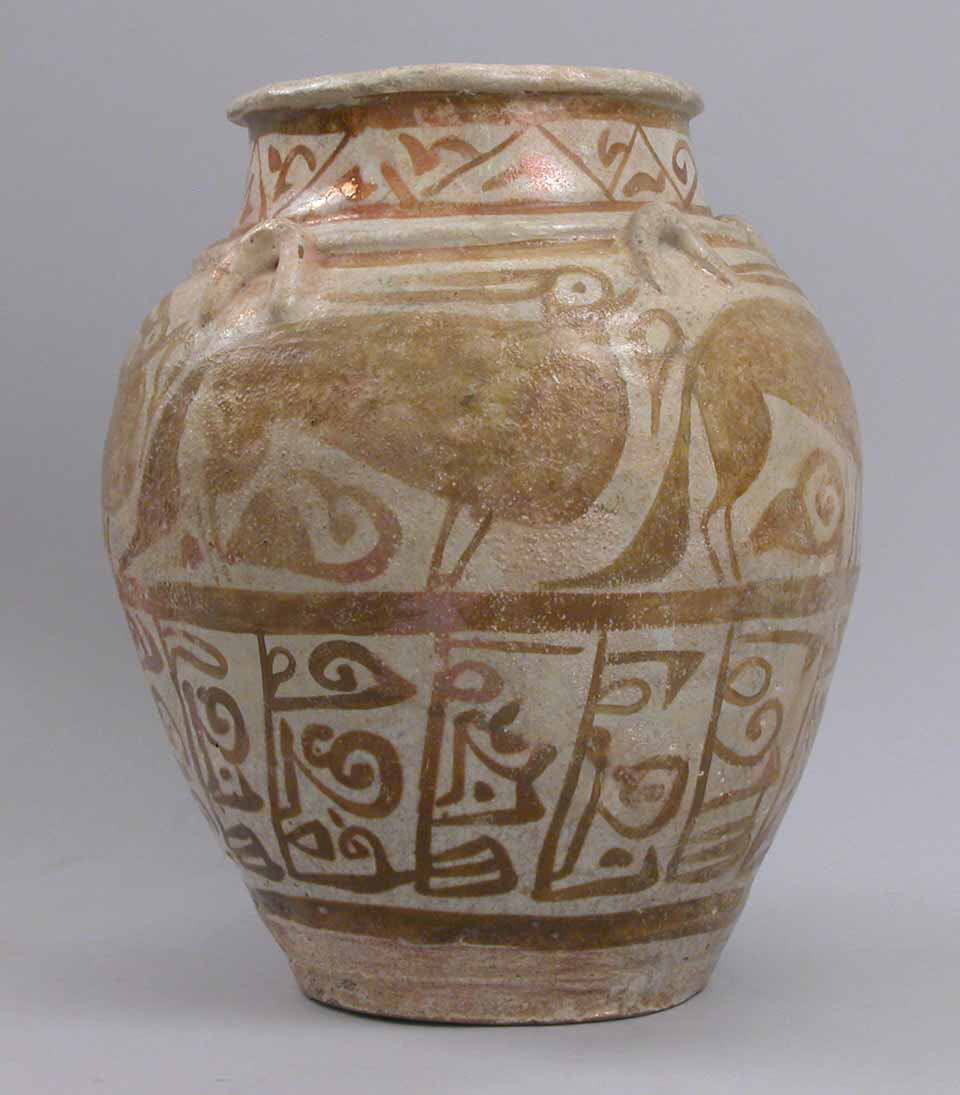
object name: jar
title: Luster Jar with Hares (?) and Inscribed Words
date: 901-1000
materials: earthenware, glaze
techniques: luster painting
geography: iraq